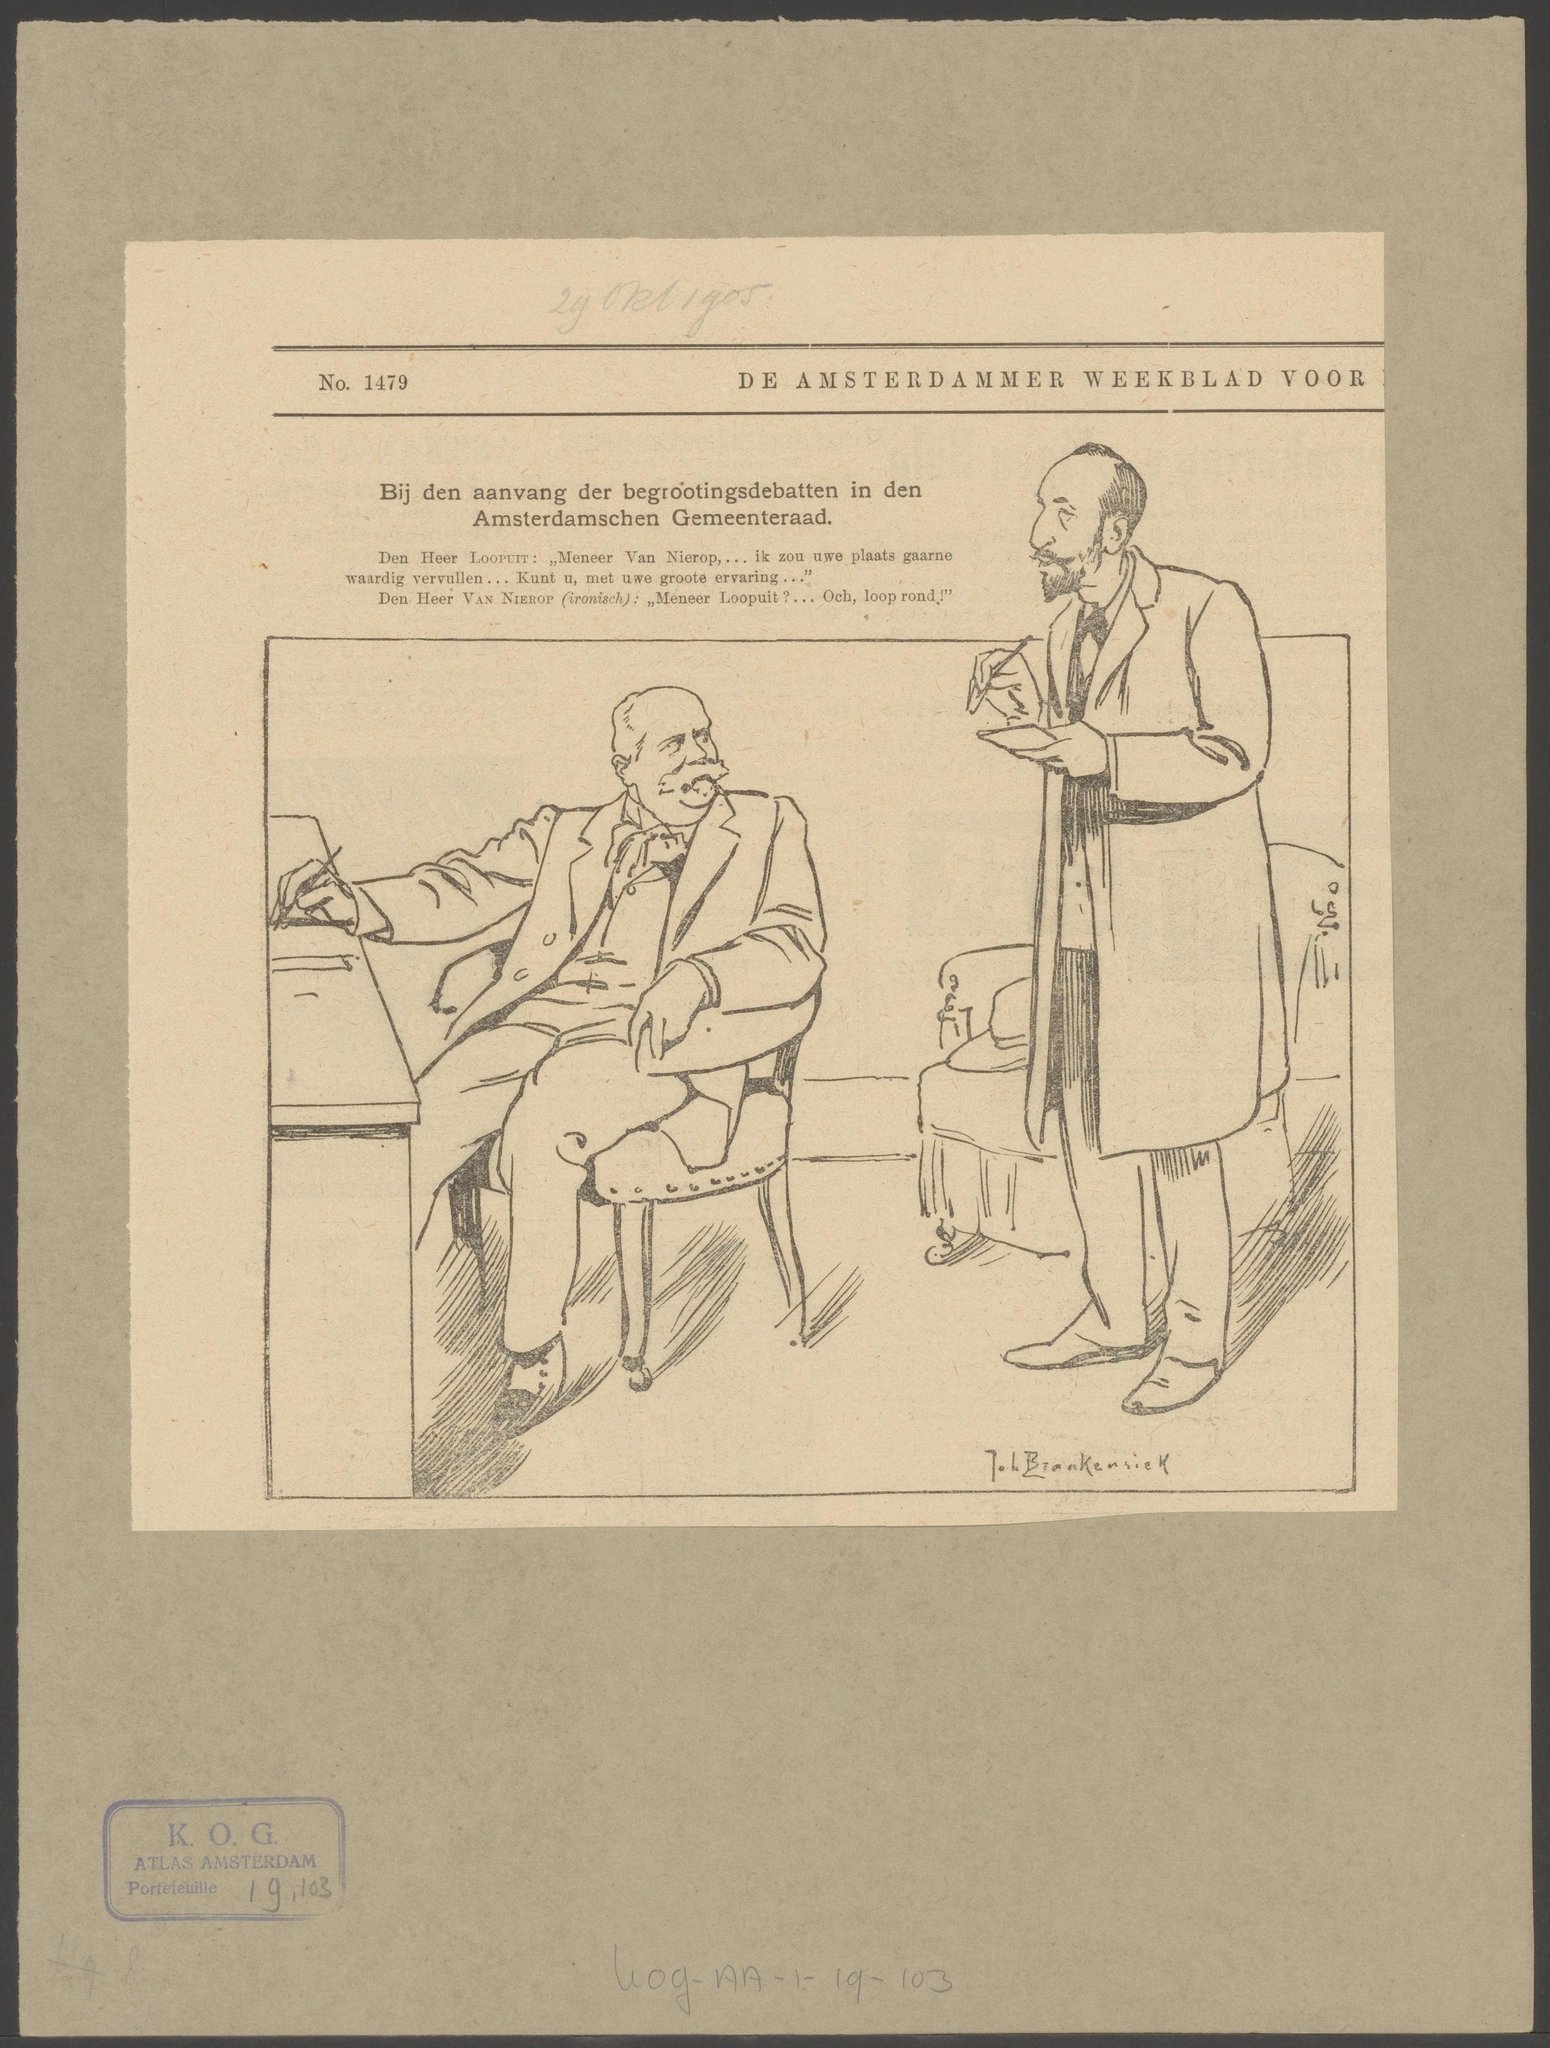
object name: photomechanical print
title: Spotprent op Frederik Salomon van Nierop en Joseph Loopuit en een gezicht op een vergadering van de Amsterdamse Gemeenteraad in de Mozeszaal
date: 1905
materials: paper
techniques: letterpress printing, line block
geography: amsterdam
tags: politician, city council, politician, e.g. party leader, political caricatures and satires, amsterdam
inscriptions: collector's mark: ‘19,103’ Lugt 1641b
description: Onderwerpsrubriek binnen de Atlas Amsterdam: Herinneringen aan regeringsleden en hunne huisgezinnen [na 1800].